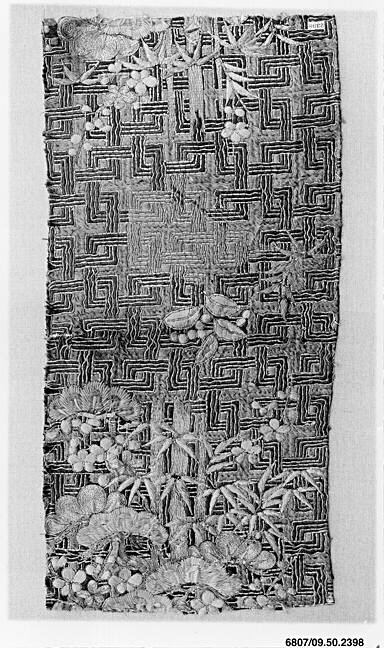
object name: piece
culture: japanese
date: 1801-1900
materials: metal thread, silk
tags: leaves